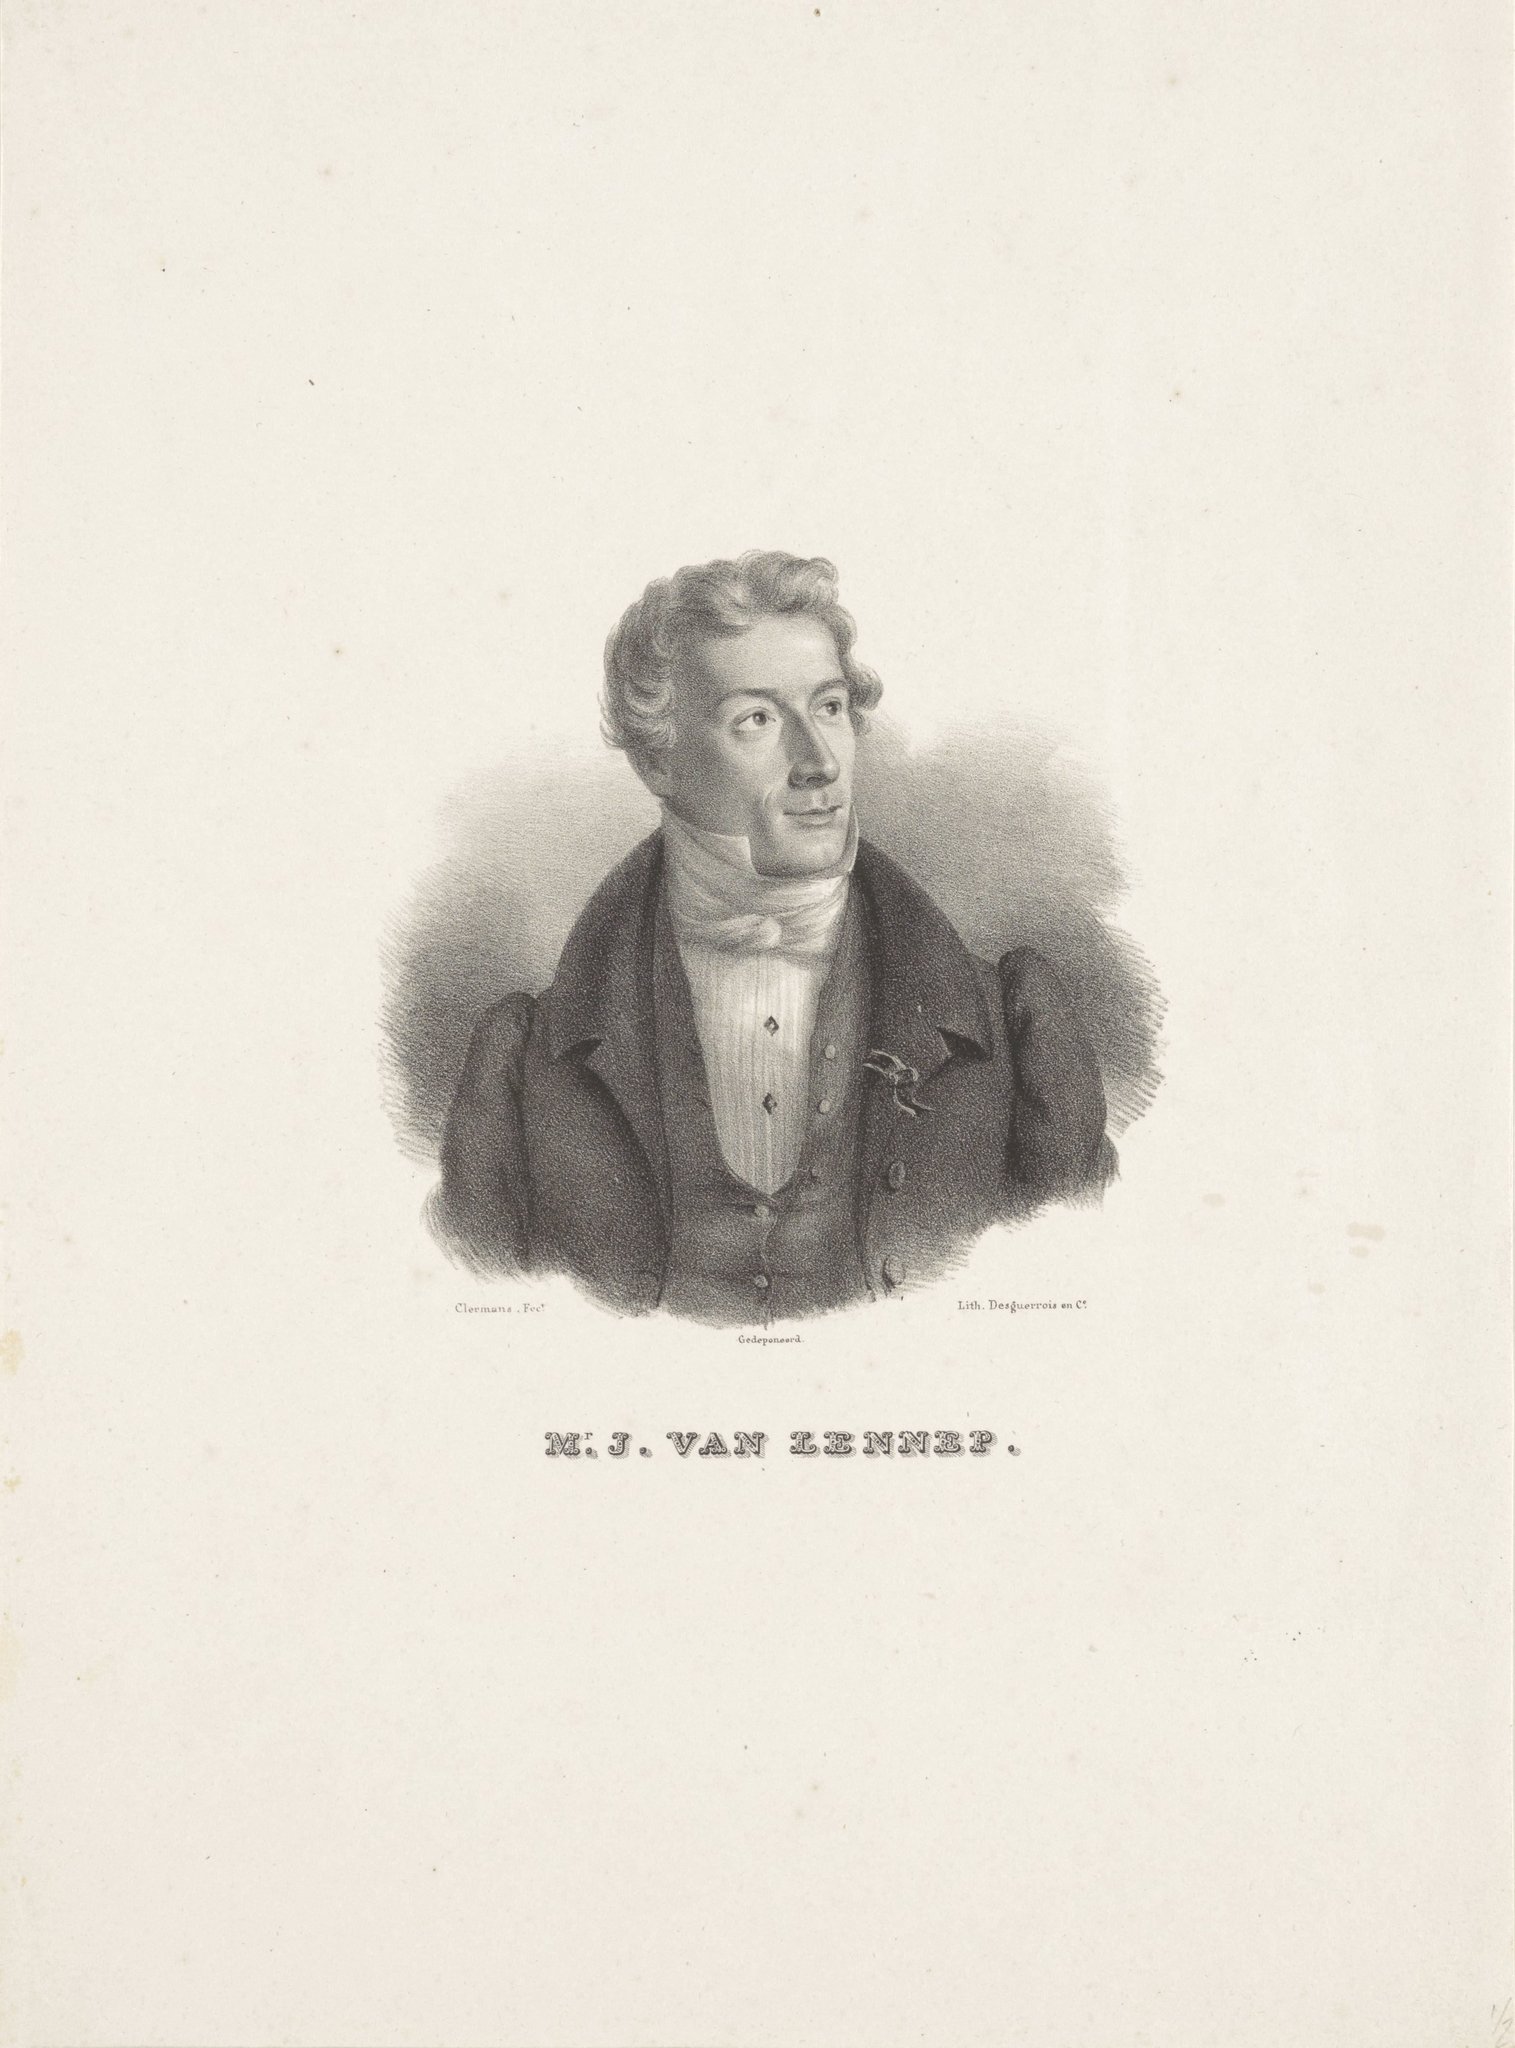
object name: print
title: Portret Jacob van Lennep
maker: j.b. clermans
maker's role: print maker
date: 1826-1839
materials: paper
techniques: lithograph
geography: amsterdam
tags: amsterdam, jacob van lennep, knighthood order, historical persons (+ (full) bust portrait)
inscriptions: : ‘Gedeponeerd.’, collector's mark: Lugt 2228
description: De geportretteerde draagt een open jas met opstaande kraag. Hij kijkt naar rechts. Op de revers, bevestigd aan een knoop, draagt hij een onderscheiding. Onder het portret zijn naam.